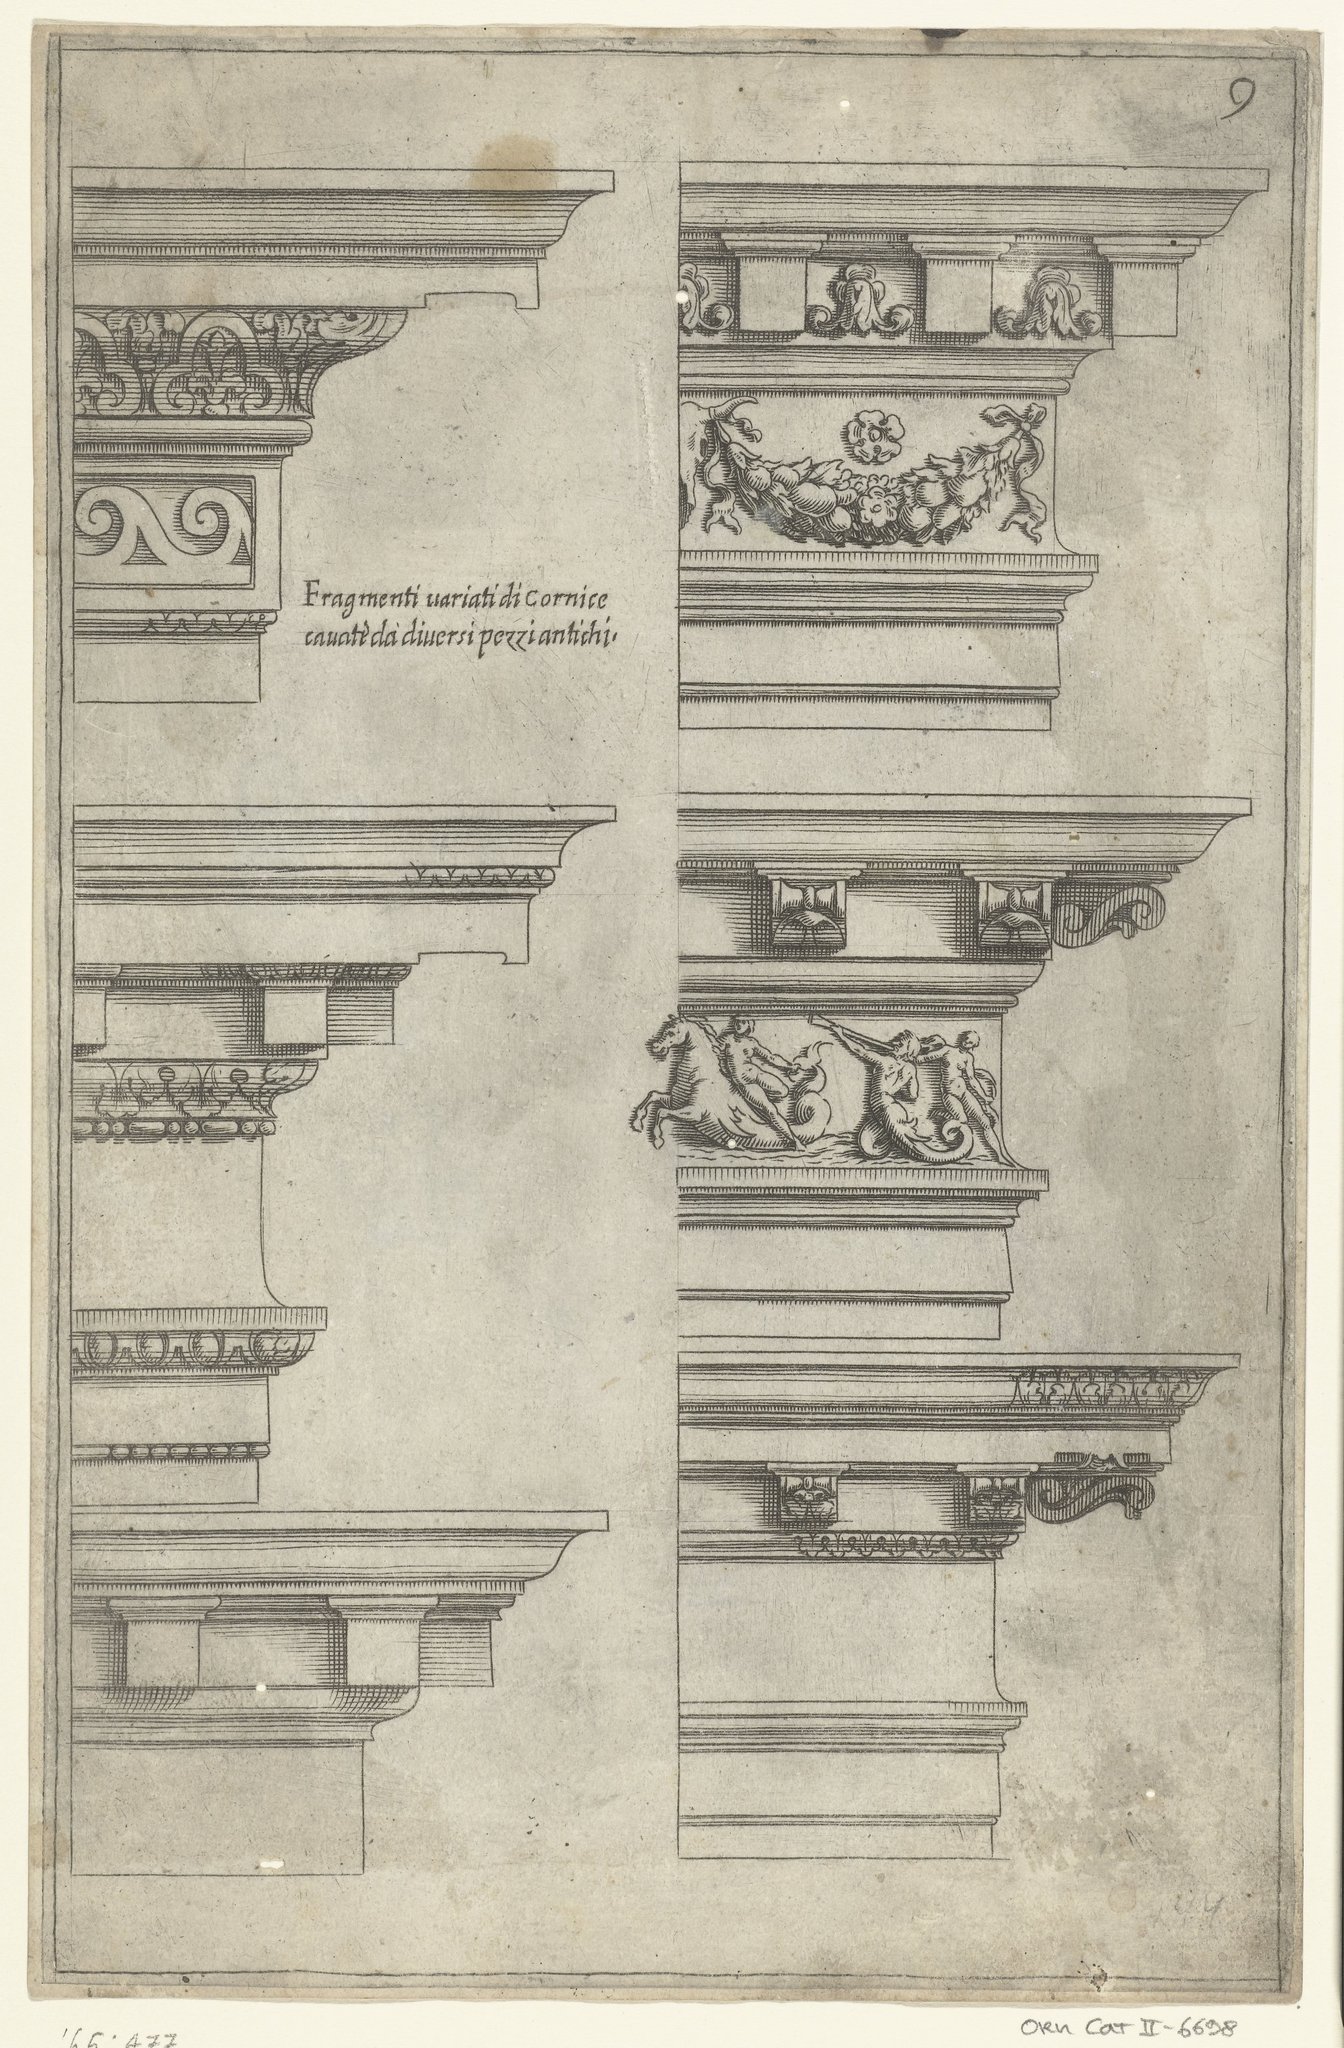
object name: print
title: Architettura con diversi ornamenti cavati dall' Antico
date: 1636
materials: paper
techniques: engraving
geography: rome